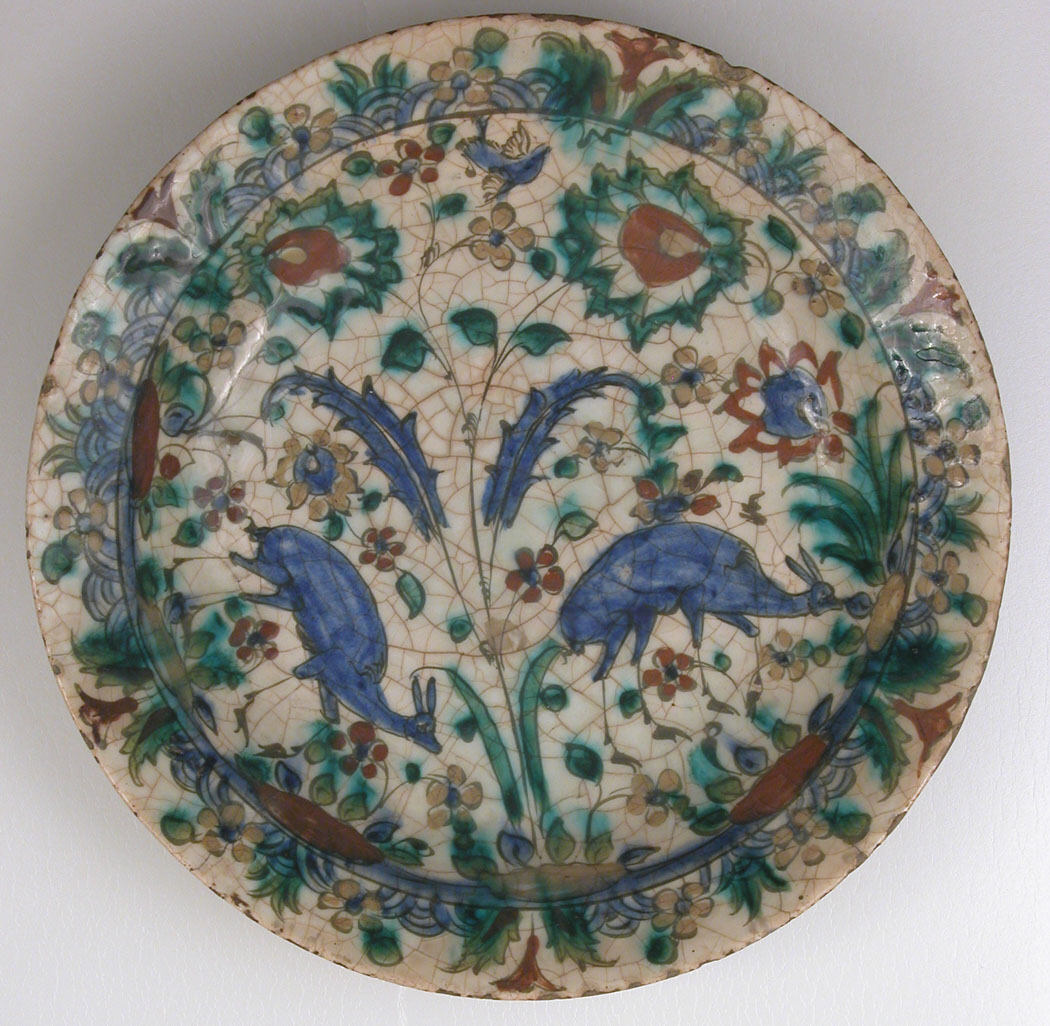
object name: dish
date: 1601-1700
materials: stonepaste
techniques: painting, underglaze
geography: iran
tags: animals,flowers,leaves